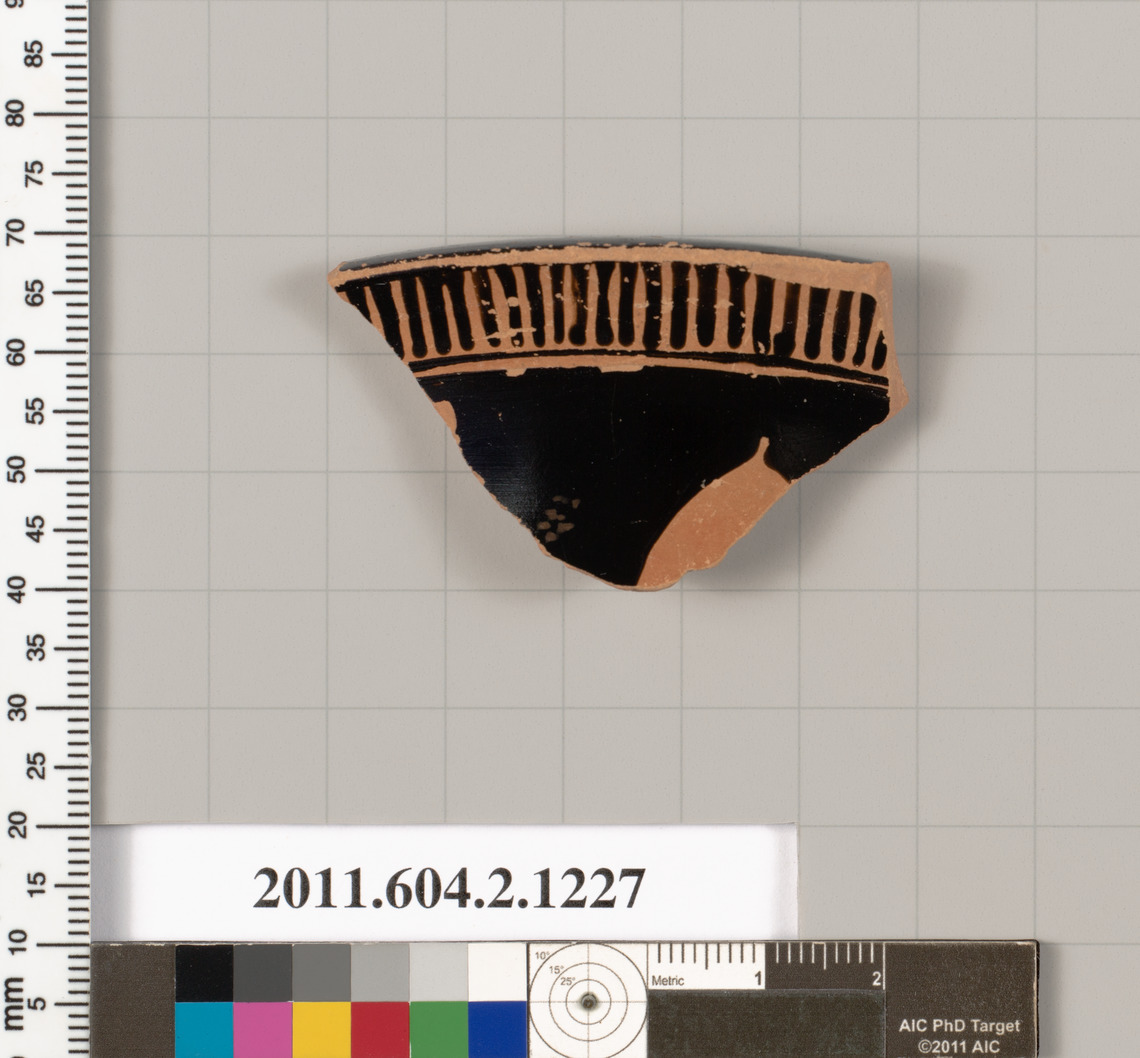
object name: rhyton fragment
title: Terracotta rhyton (vase for libations or drinking)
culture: greek, attic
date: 475-451 BCE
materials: terracotta